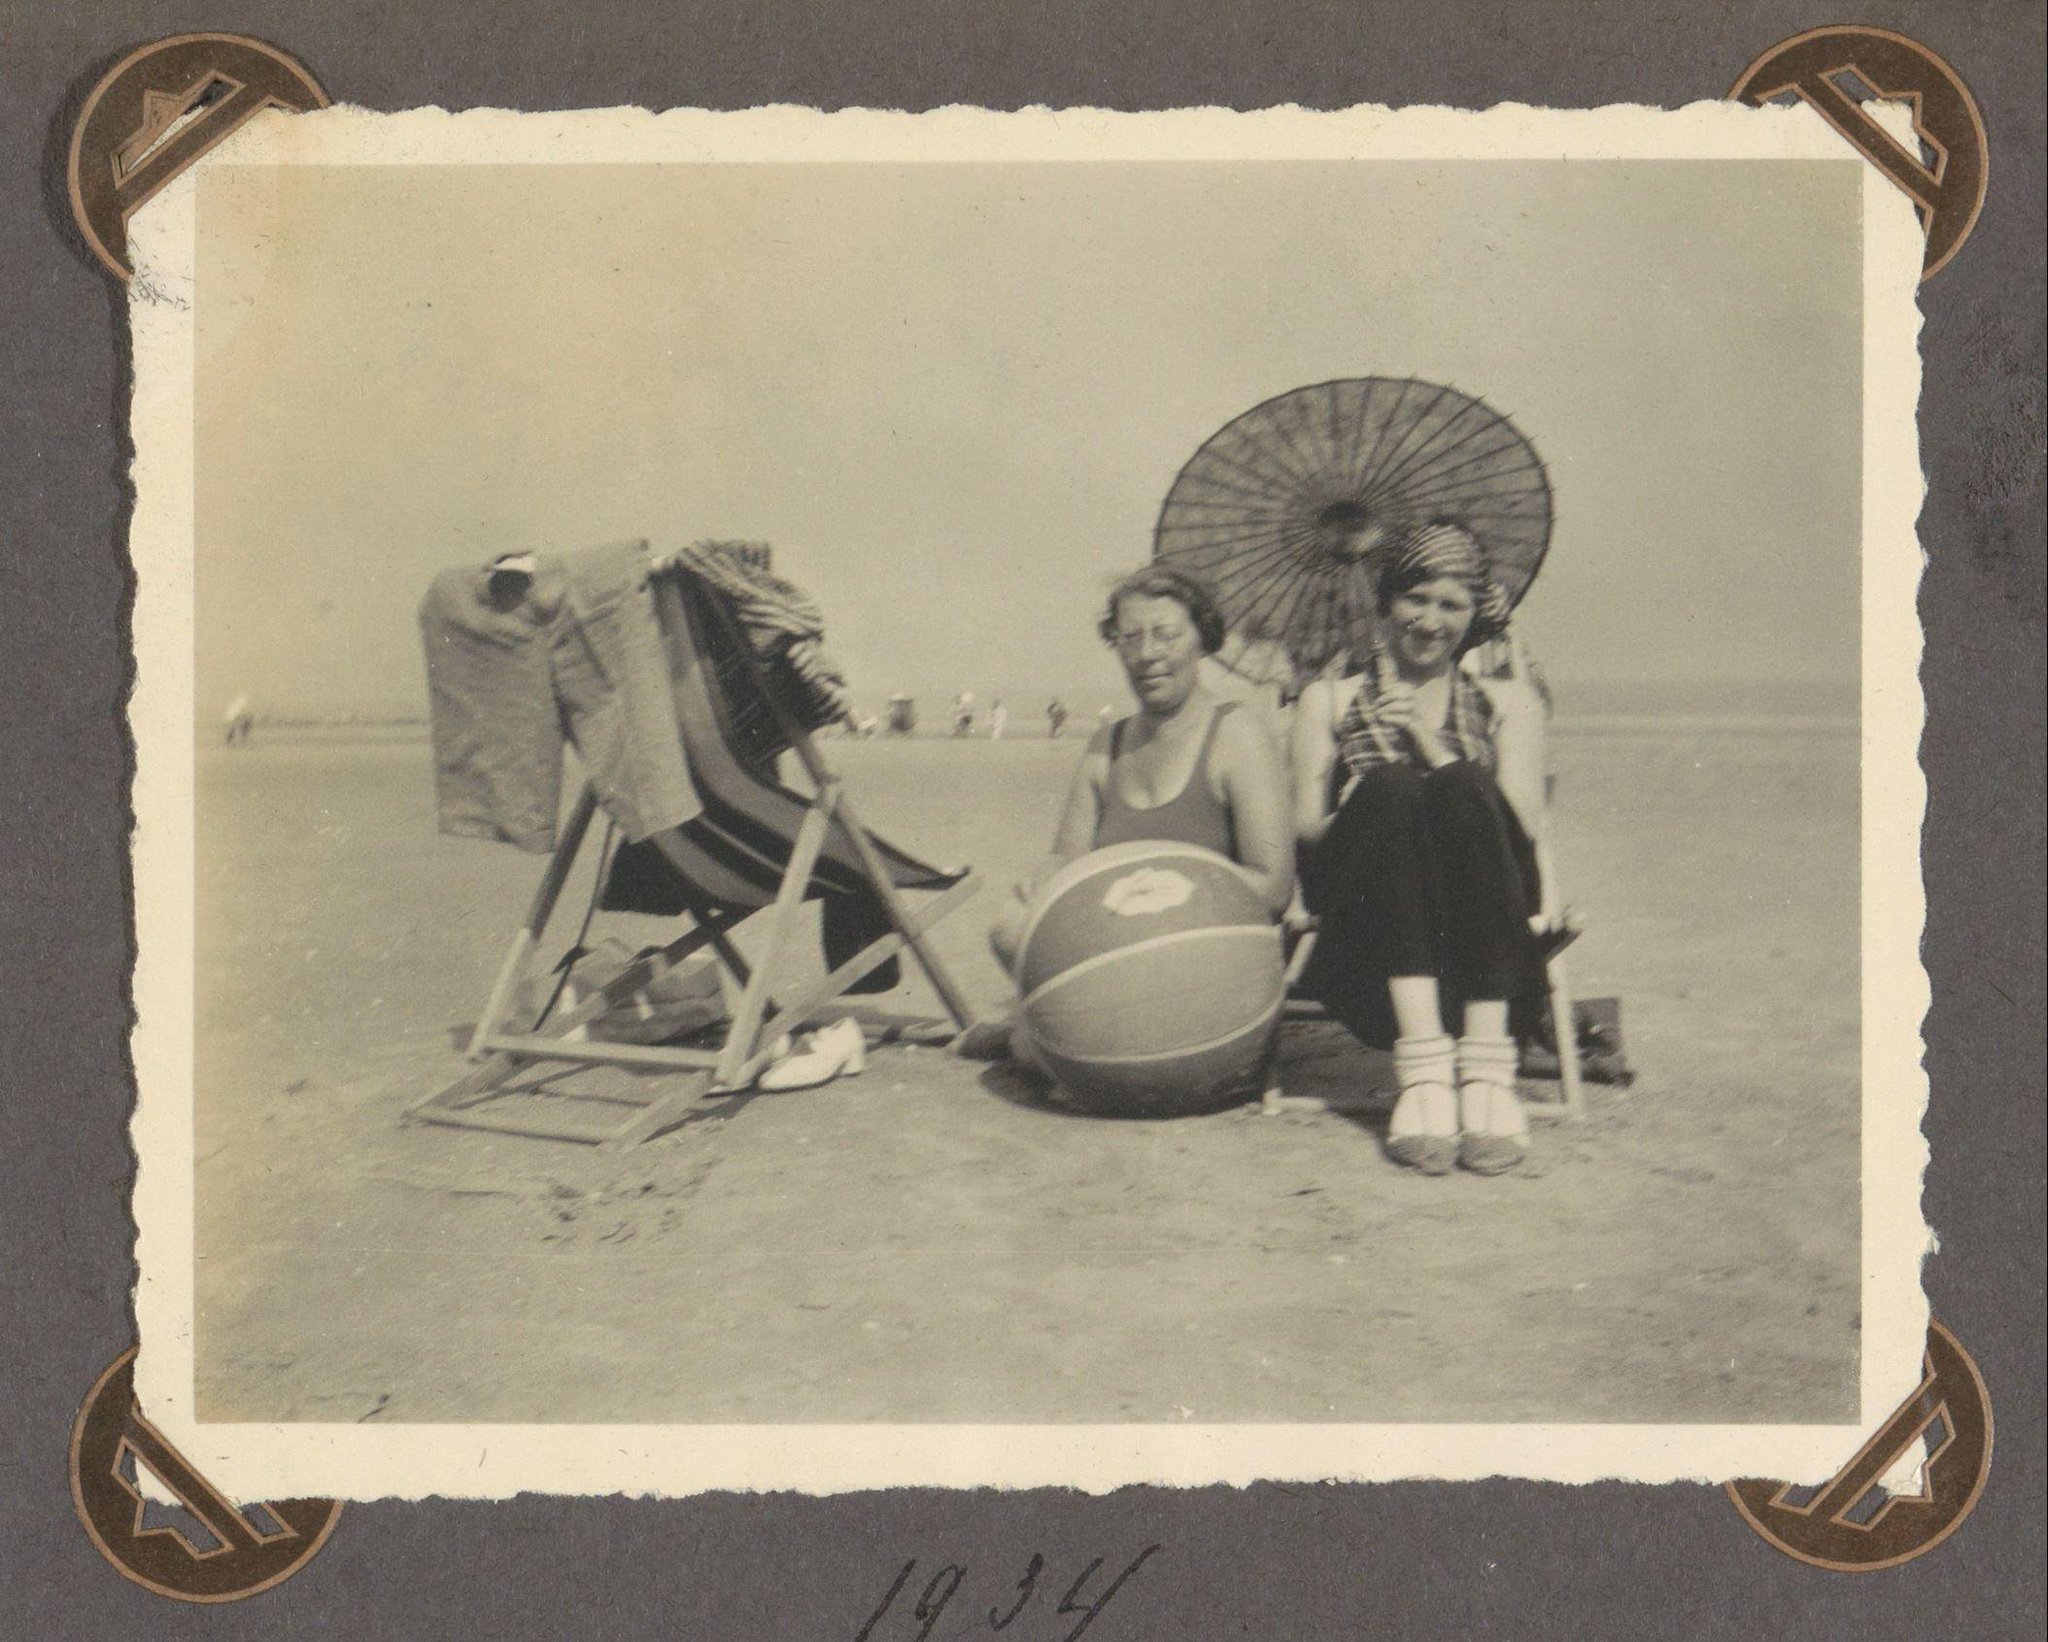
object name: photograph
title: Twee vrouwen aan het strand, omringd door strandspullen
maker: Anonymous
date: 1934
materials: photographic support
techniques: gelatin silver print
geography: netherlands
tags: beach (as place of recreation), adult woman, parasol, sunshade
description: Onderdeel van Fotoalbum met opnames van vakanties in Zuid-Frankrijk.